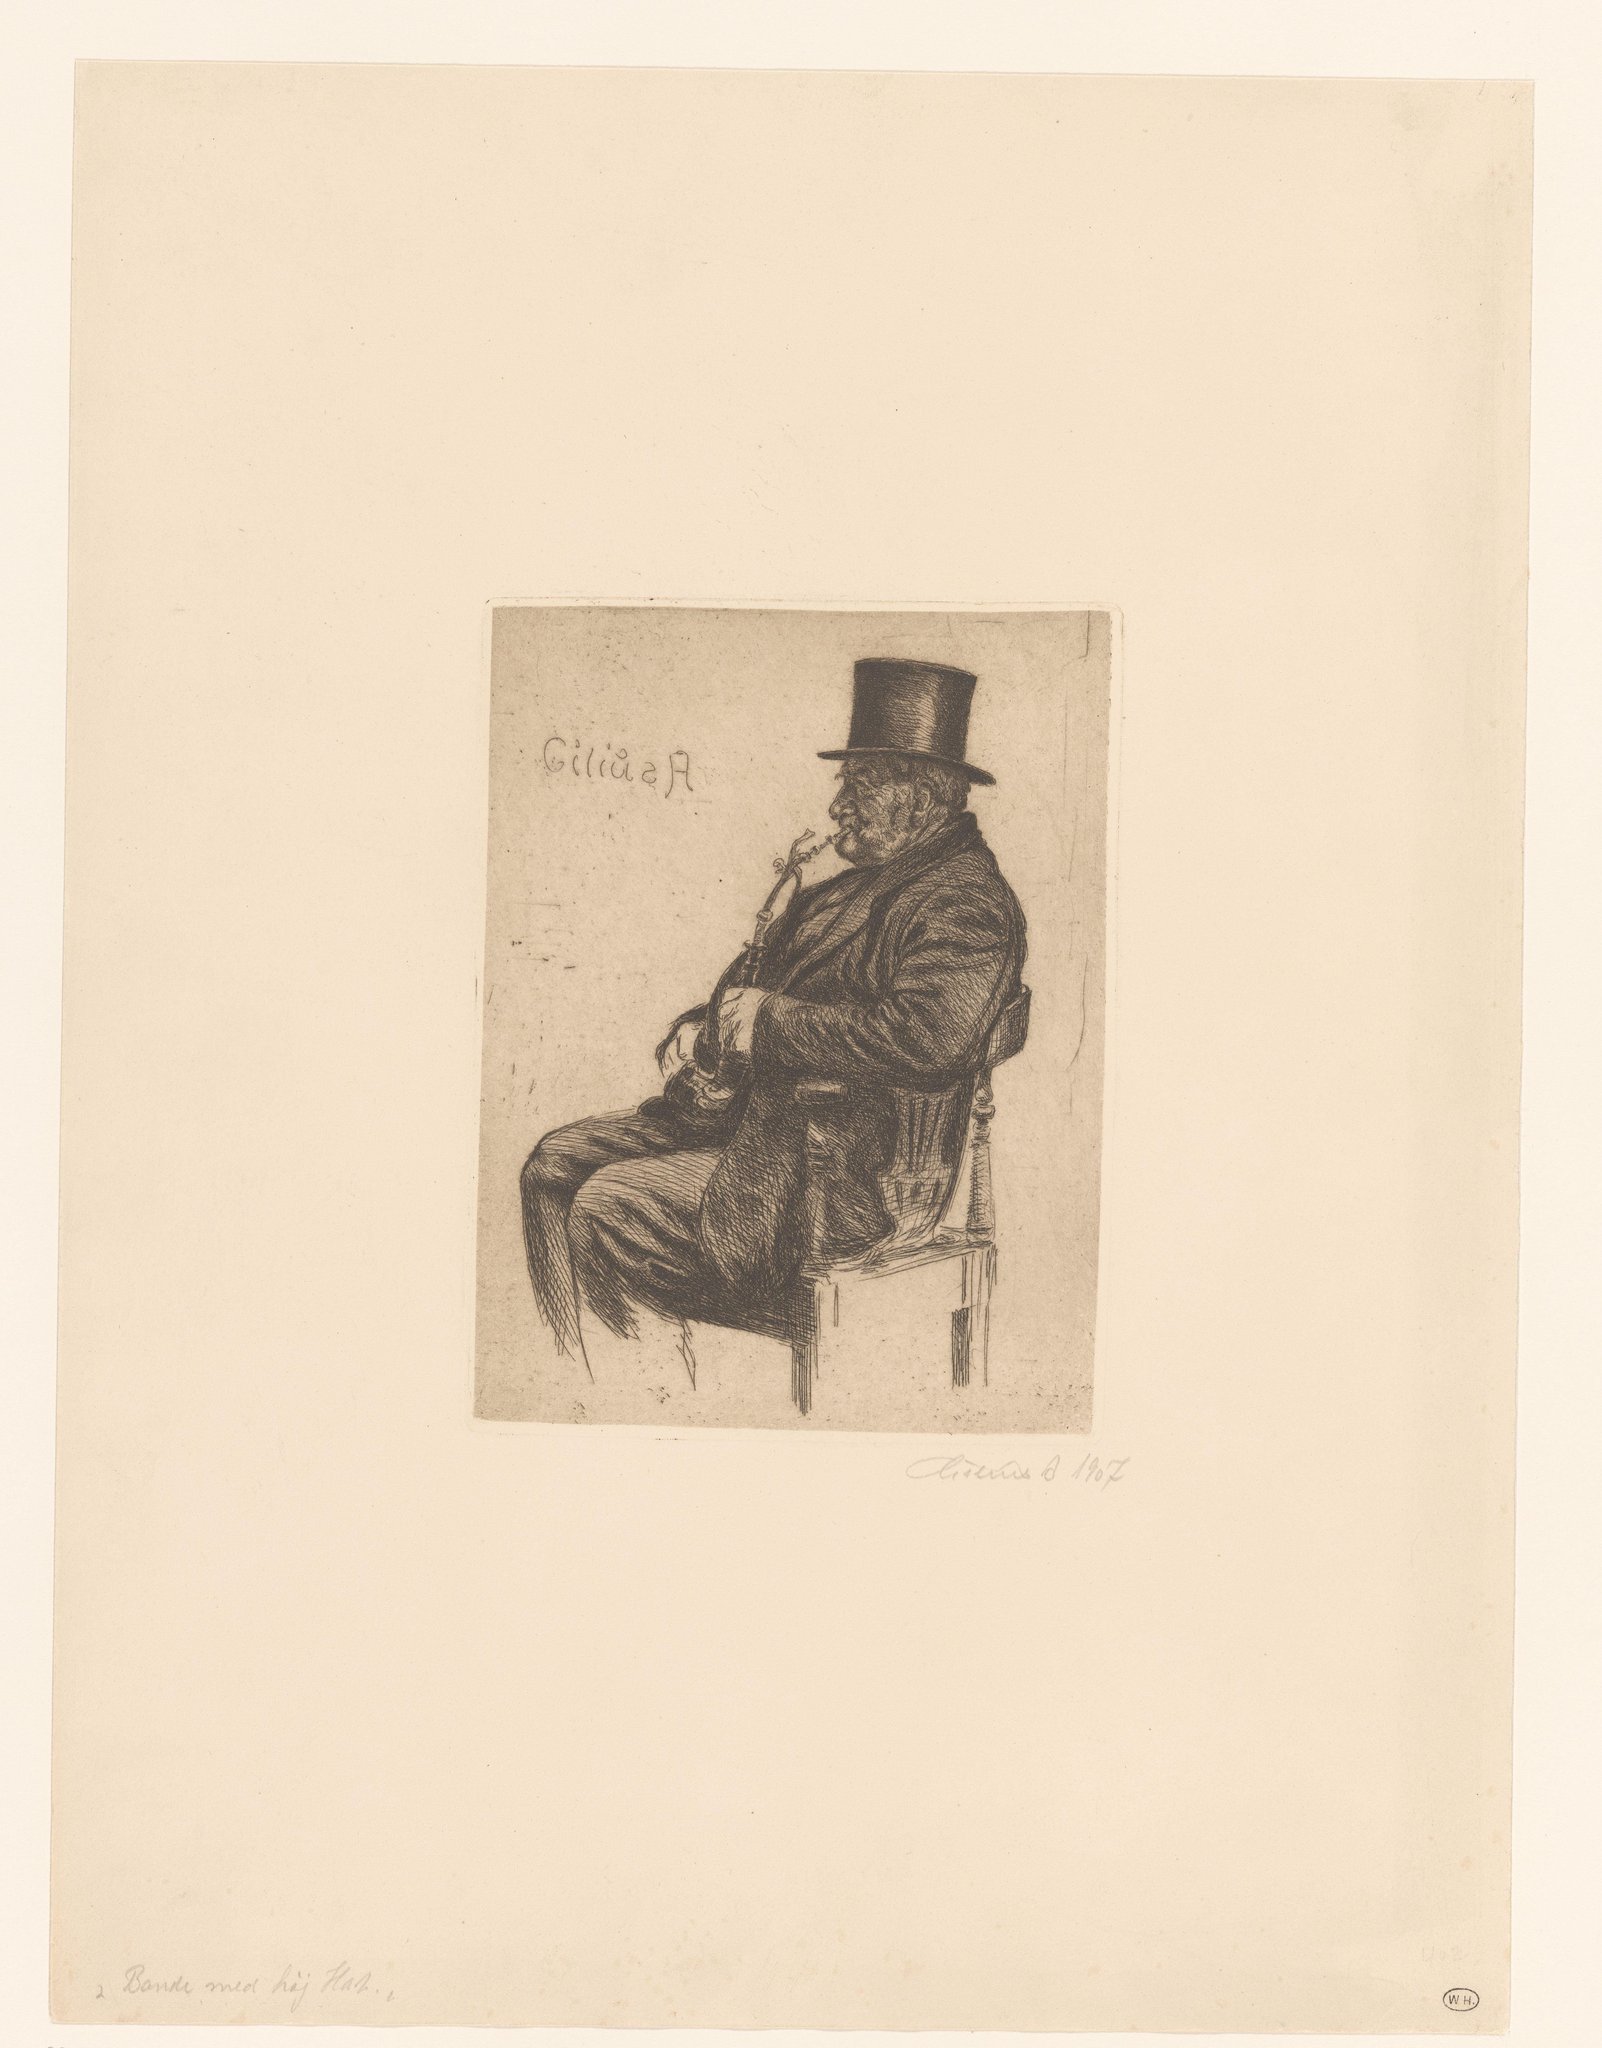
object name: print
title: Pijprokende man op stoel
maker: a. gilius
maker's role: print maker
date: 1907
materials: paper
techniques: etching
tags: pipe ~ tobacco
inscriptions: collector's mark: Lugt 2228, collector's mark: Lugt 2625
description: Pijprokende man met hoge hoed, zittend op een stoel, naar links.